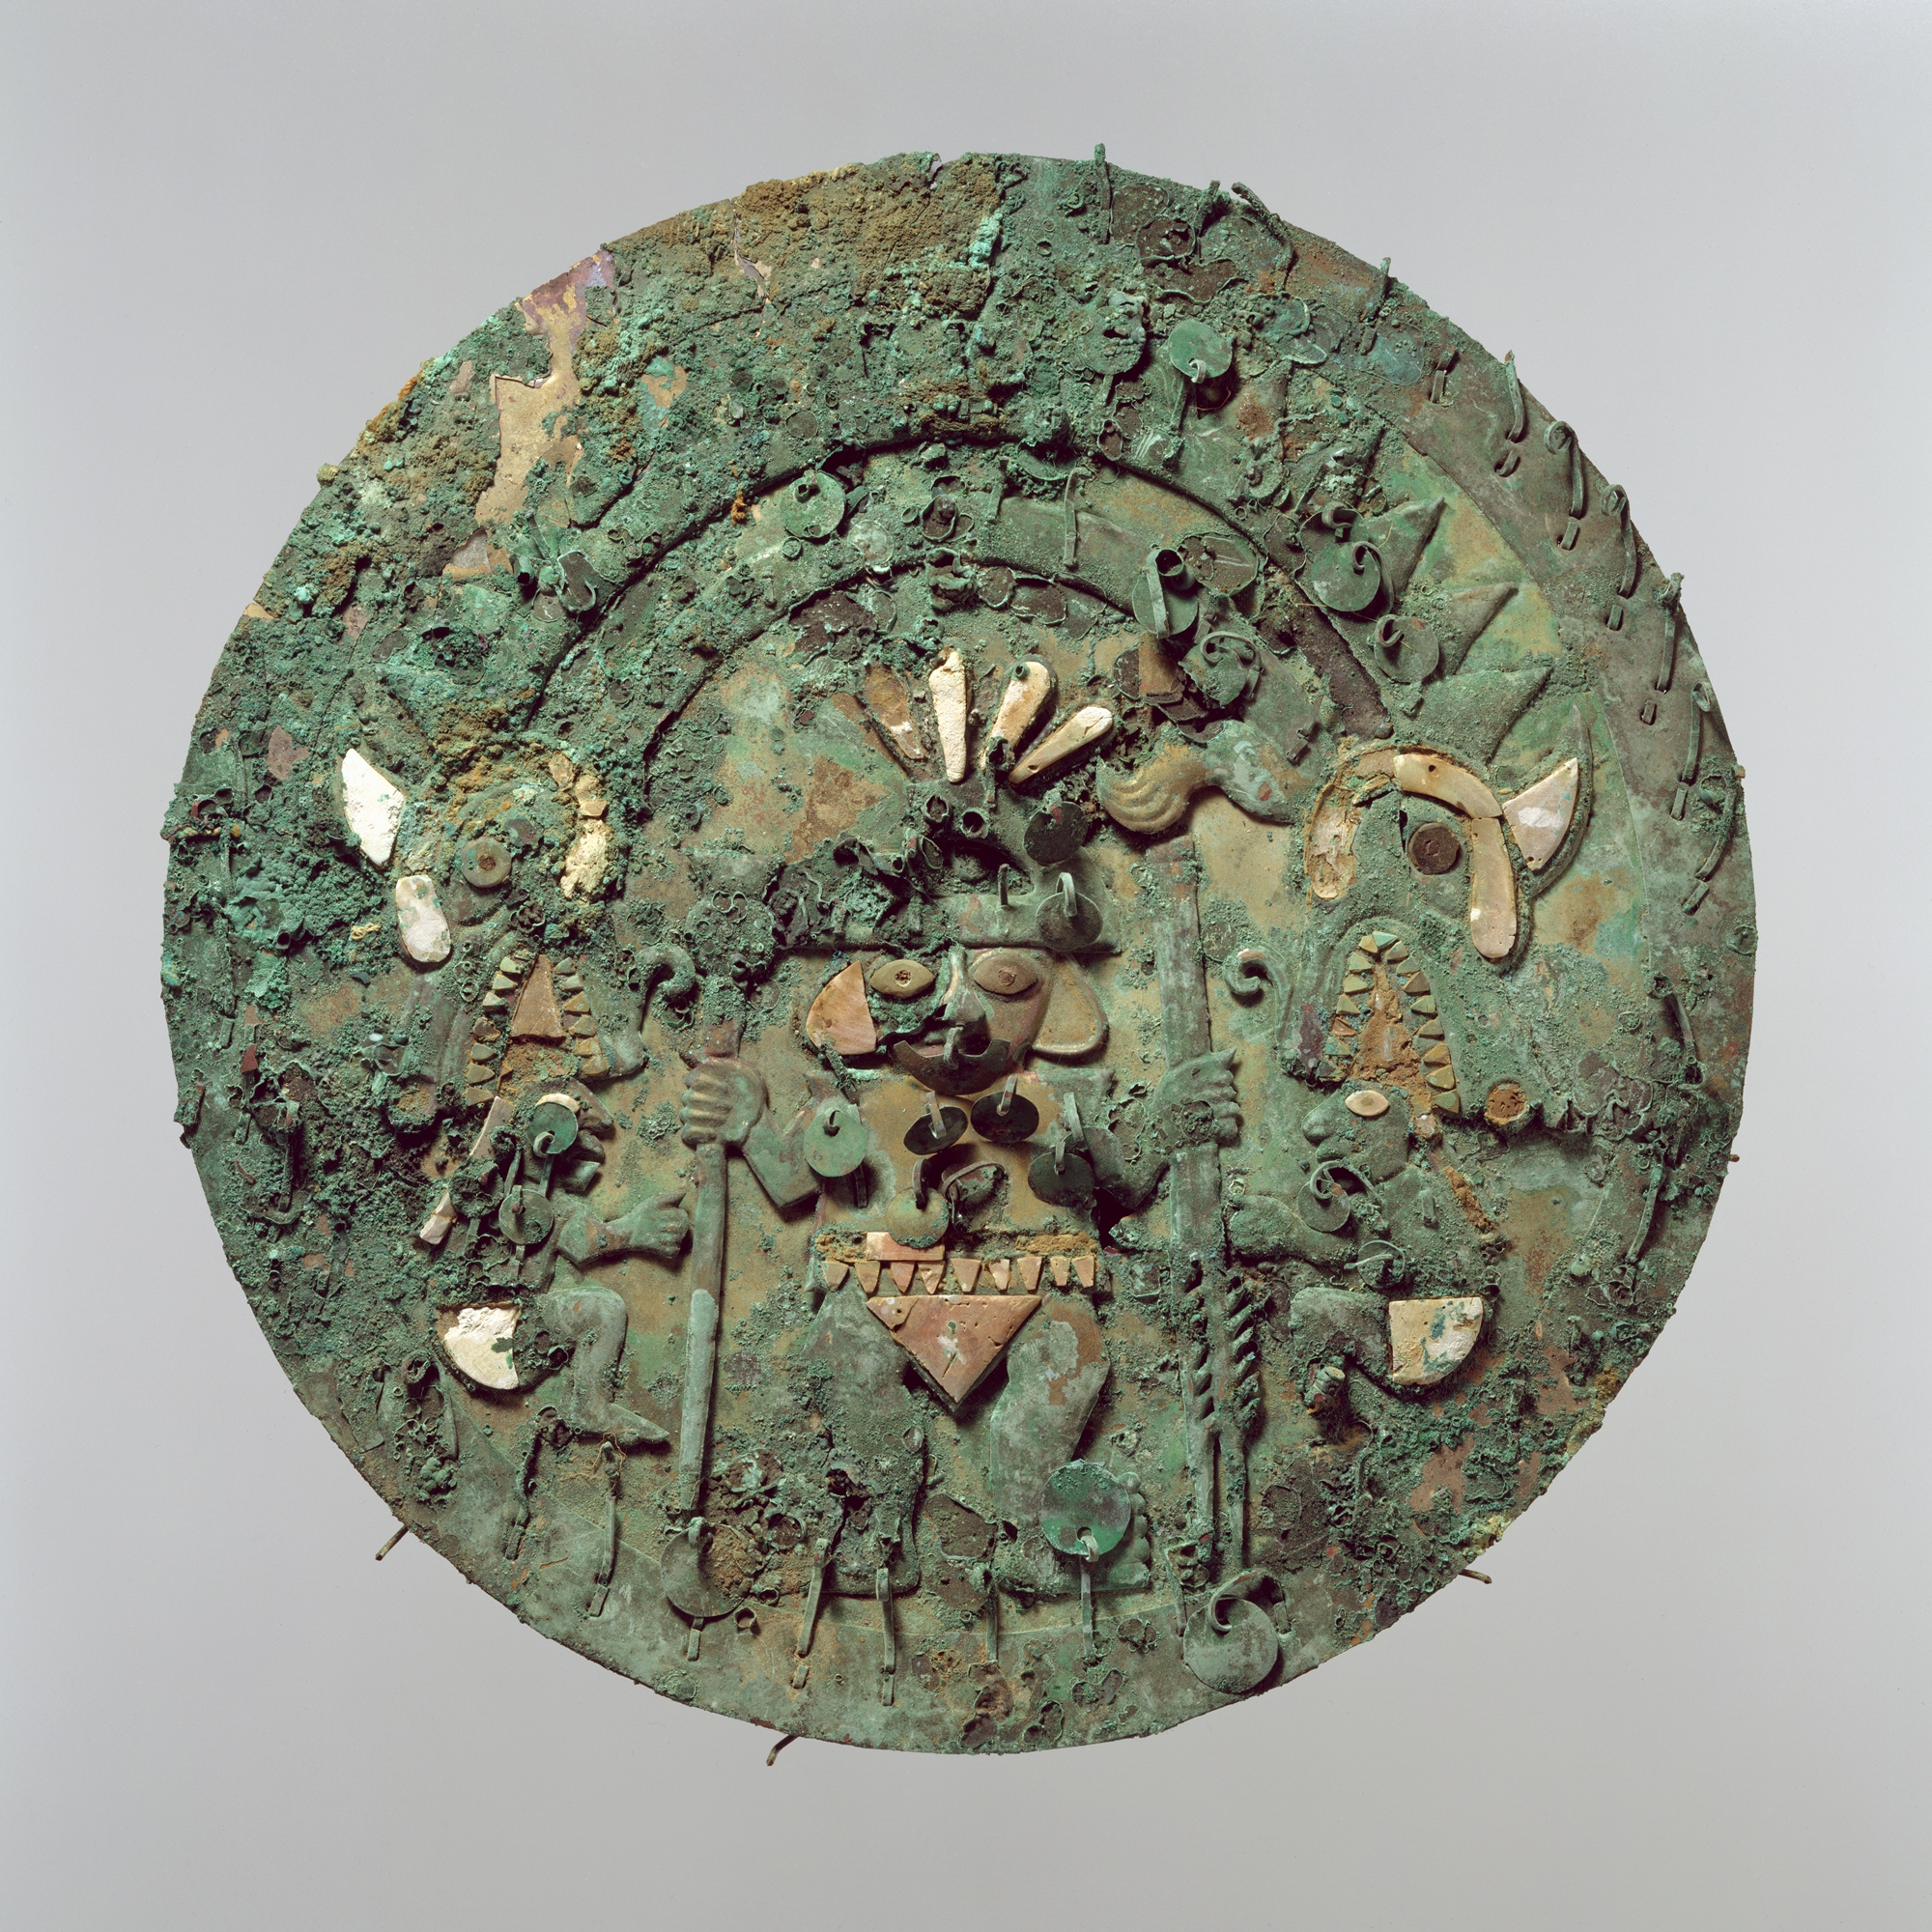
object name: disk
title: Disk with Figure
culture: moche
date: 501-700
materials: gilt copper, shell, metal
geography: peru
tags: spears,men